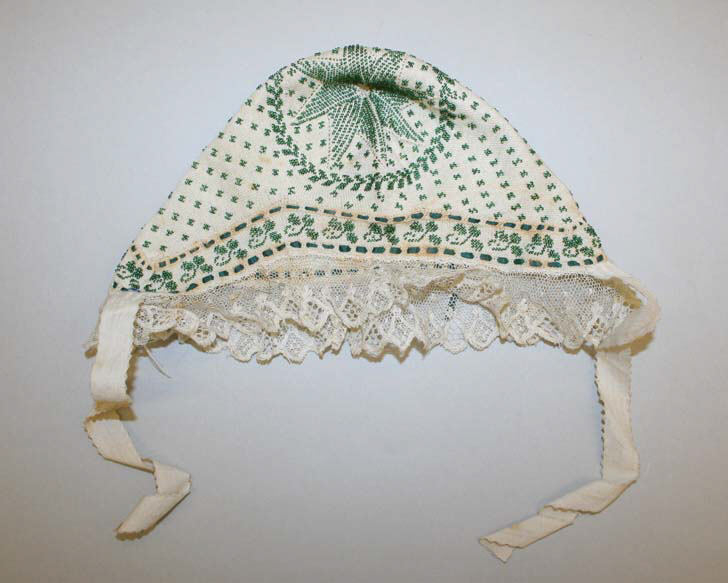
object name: cap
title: Infant's cap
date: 1801-1900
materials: cotton, glass, ribbon